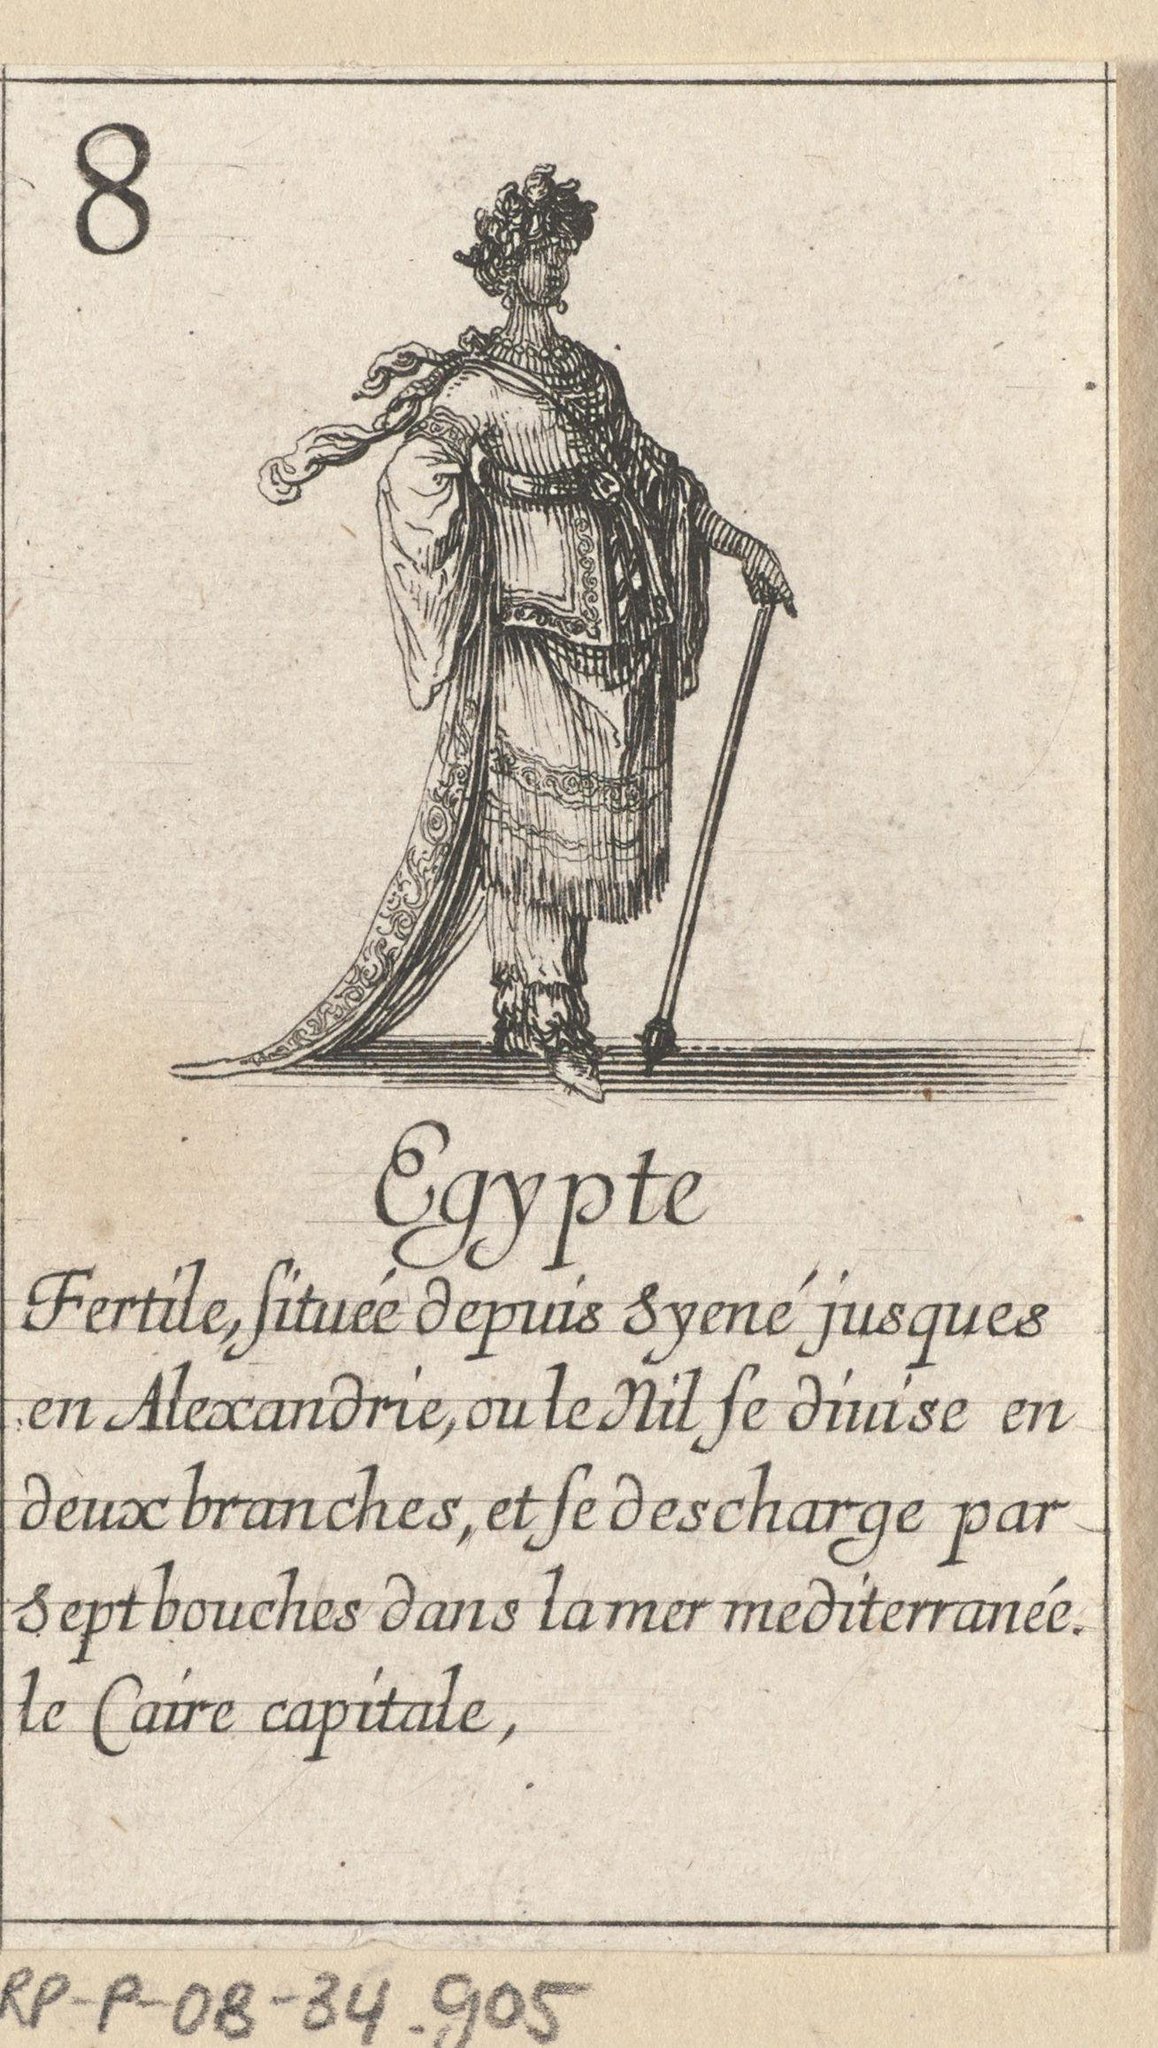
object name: playing card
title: Vrouw uit Egypte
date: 1620-1664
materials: paper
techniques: etching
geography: paris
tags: africans (+ costume)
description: Deze prent maakt deel uit van een kaartspel met 52 kaarten met voorstellingen van vrouwen uit landen over de hele wereld. De serie is uitgedacht door Jean Desmarests de Saint-Sorlin in opdracht van Kardinaal Mazarin. Het kaartspel werd gemaakt voor de jonge Lodewijk XIV, samen met het Jeu des Fables, Jeu des Reynes Renommées en Jeu des Rois de France.